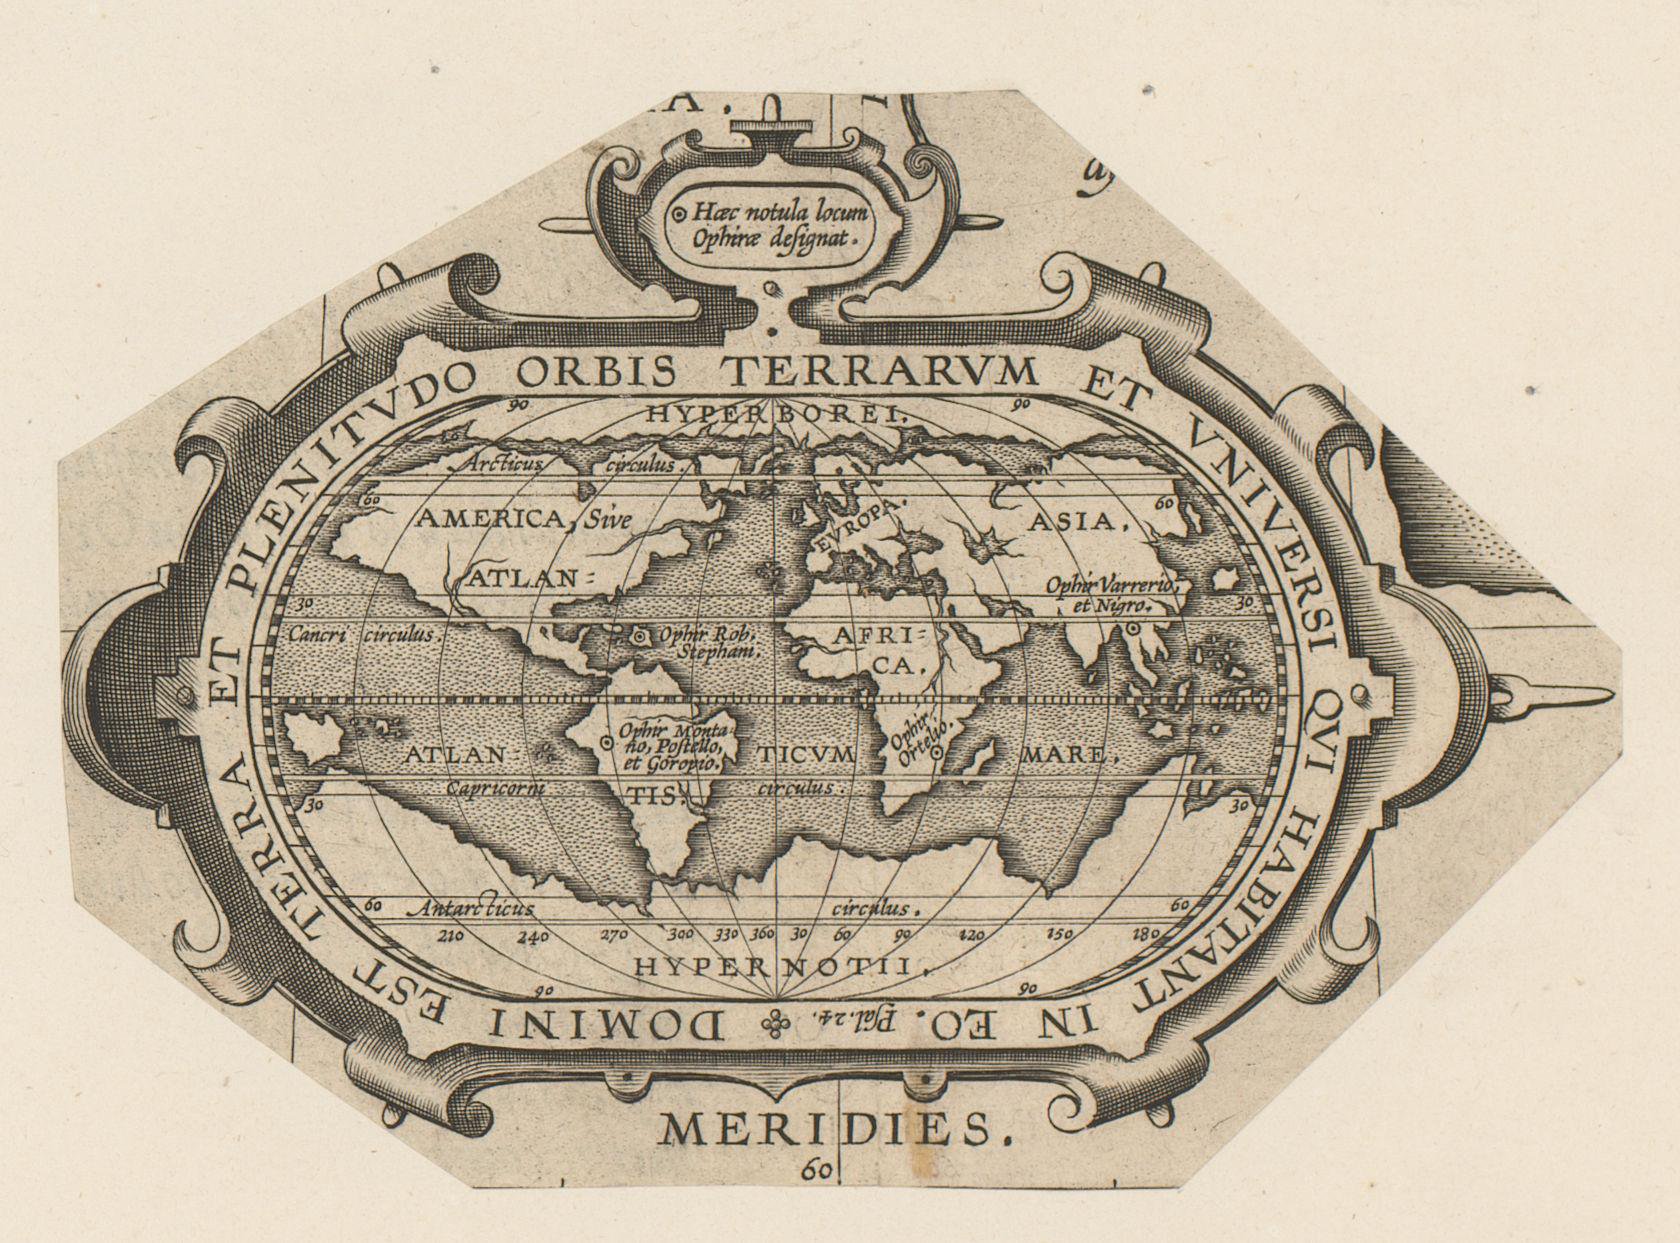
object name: ornament print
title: Geographia Sacra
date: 1598-1601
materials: paper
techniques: engraving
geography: antwerp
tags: map of the world, ornament ~ cartouche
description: Rolwerkcartouche met de wereldkaart. In de rand tekst van Psalm 24. De cartouche is een fragment van een kaart van de Oude Wereld. De prent maakt deel uit van een album.